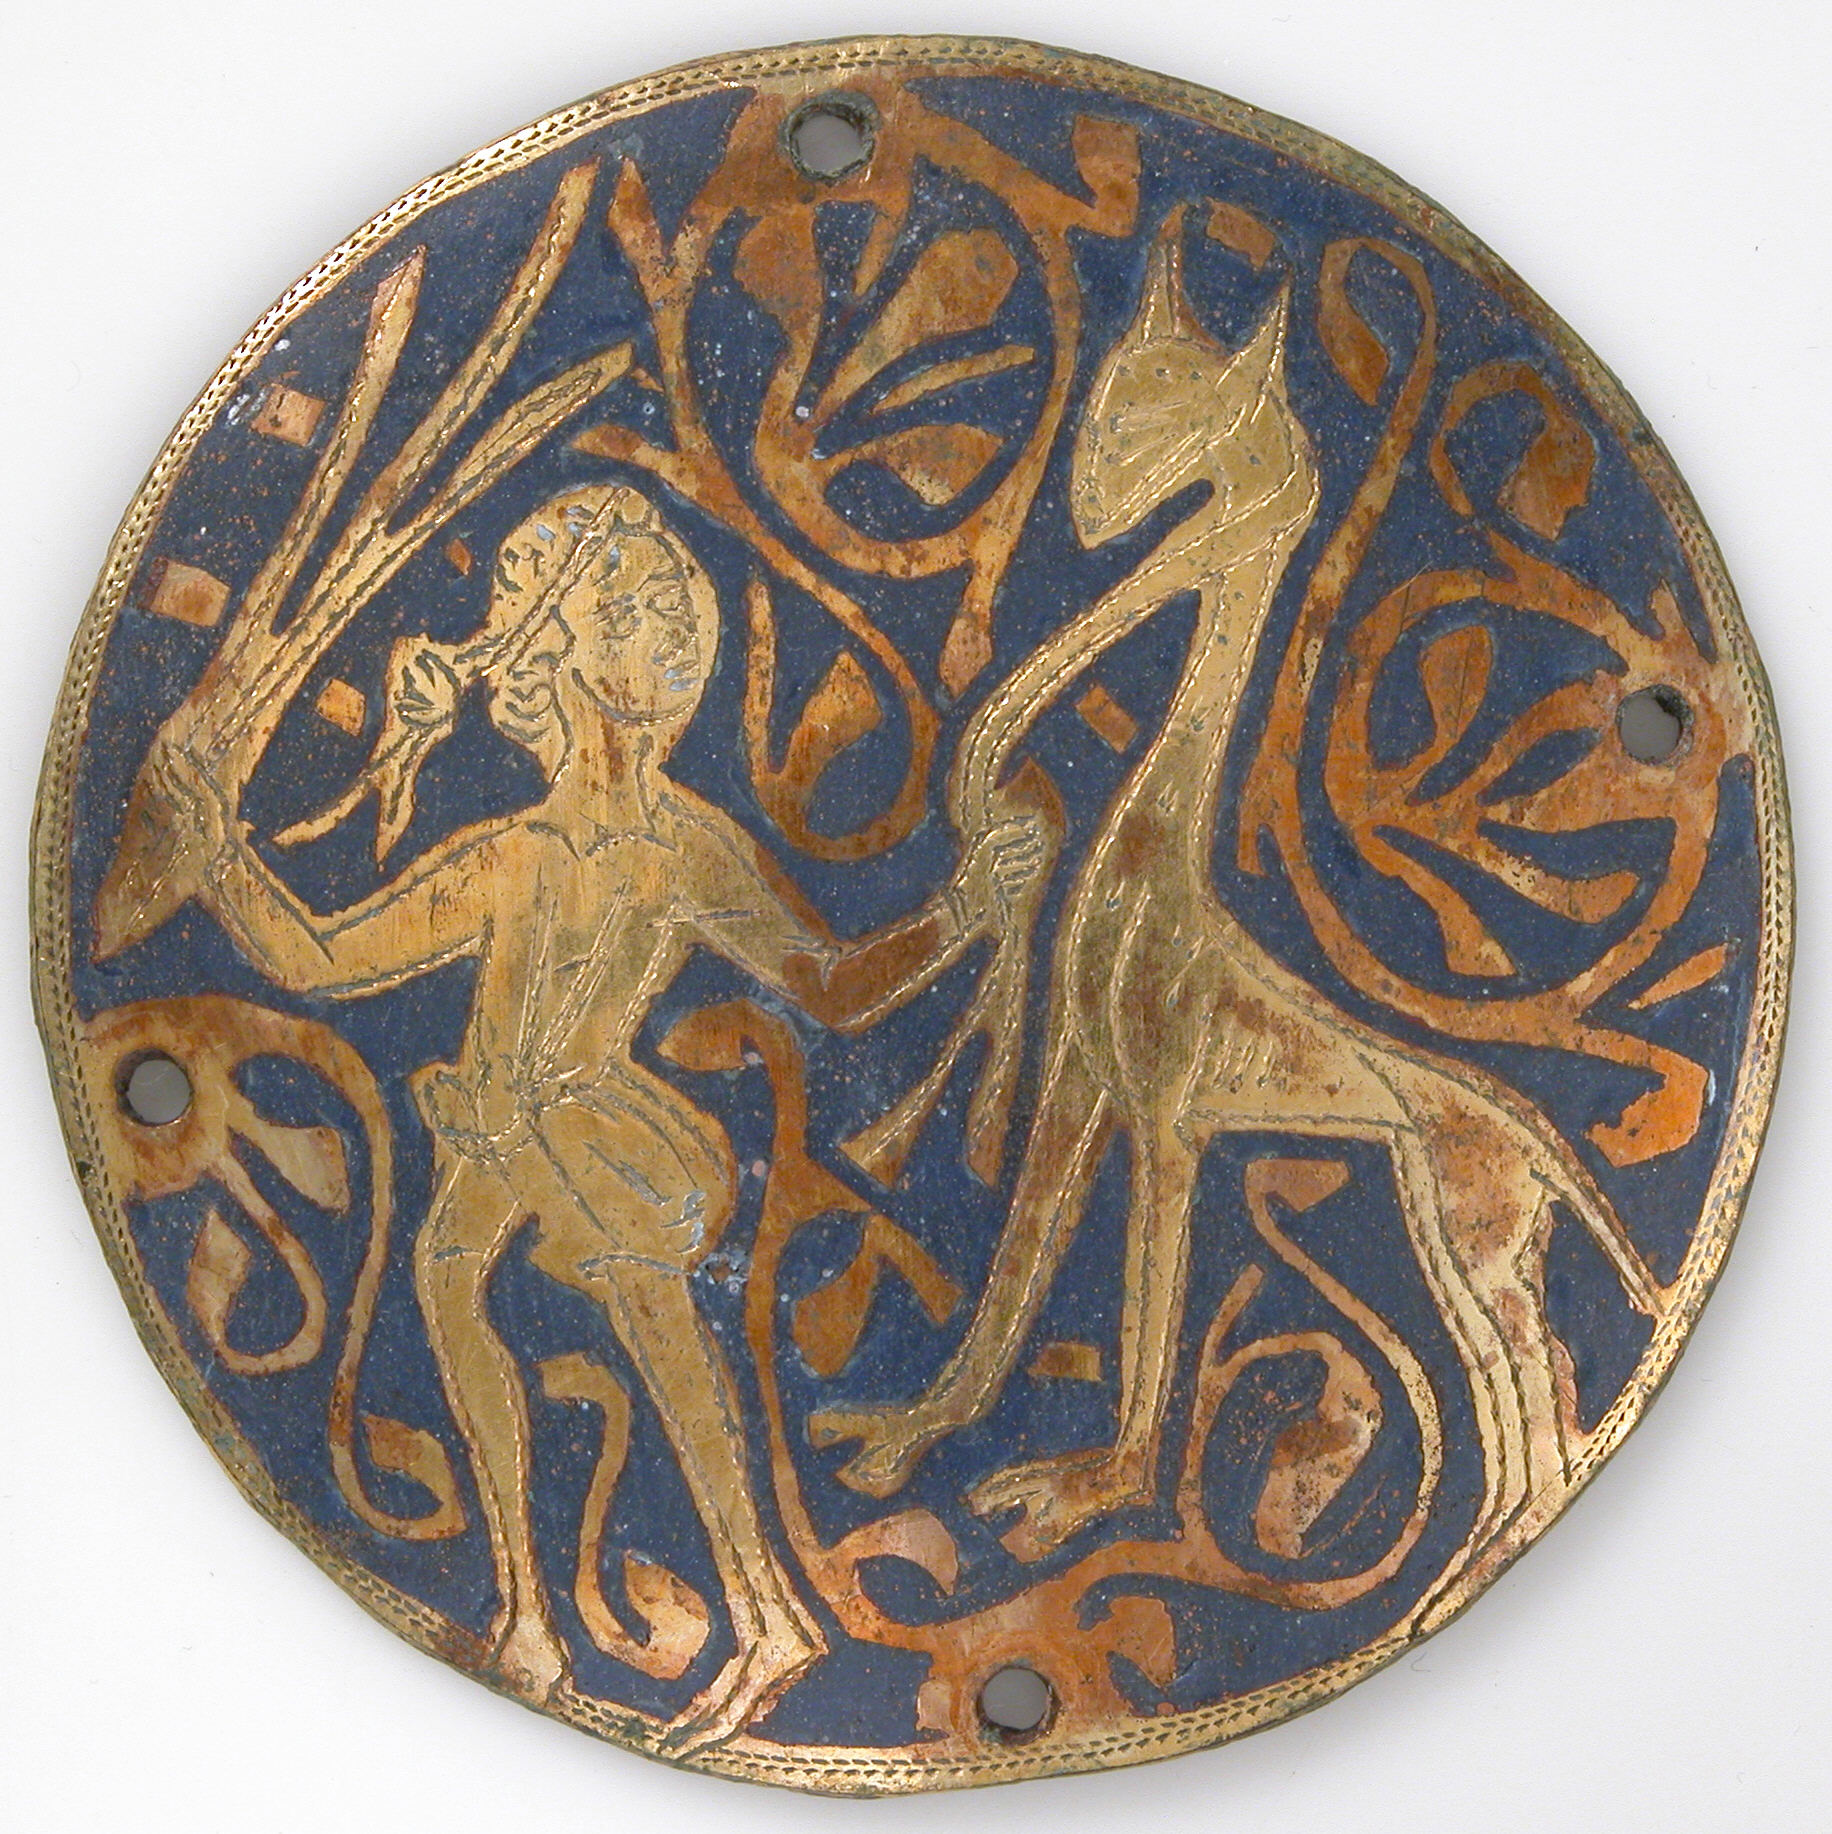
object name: medallion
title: Medallion with Youth Leading Long-necked Animal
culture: french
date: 1240-1260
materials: copper, enamel, gilt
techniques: enamel, engraving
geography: france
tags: animals,men